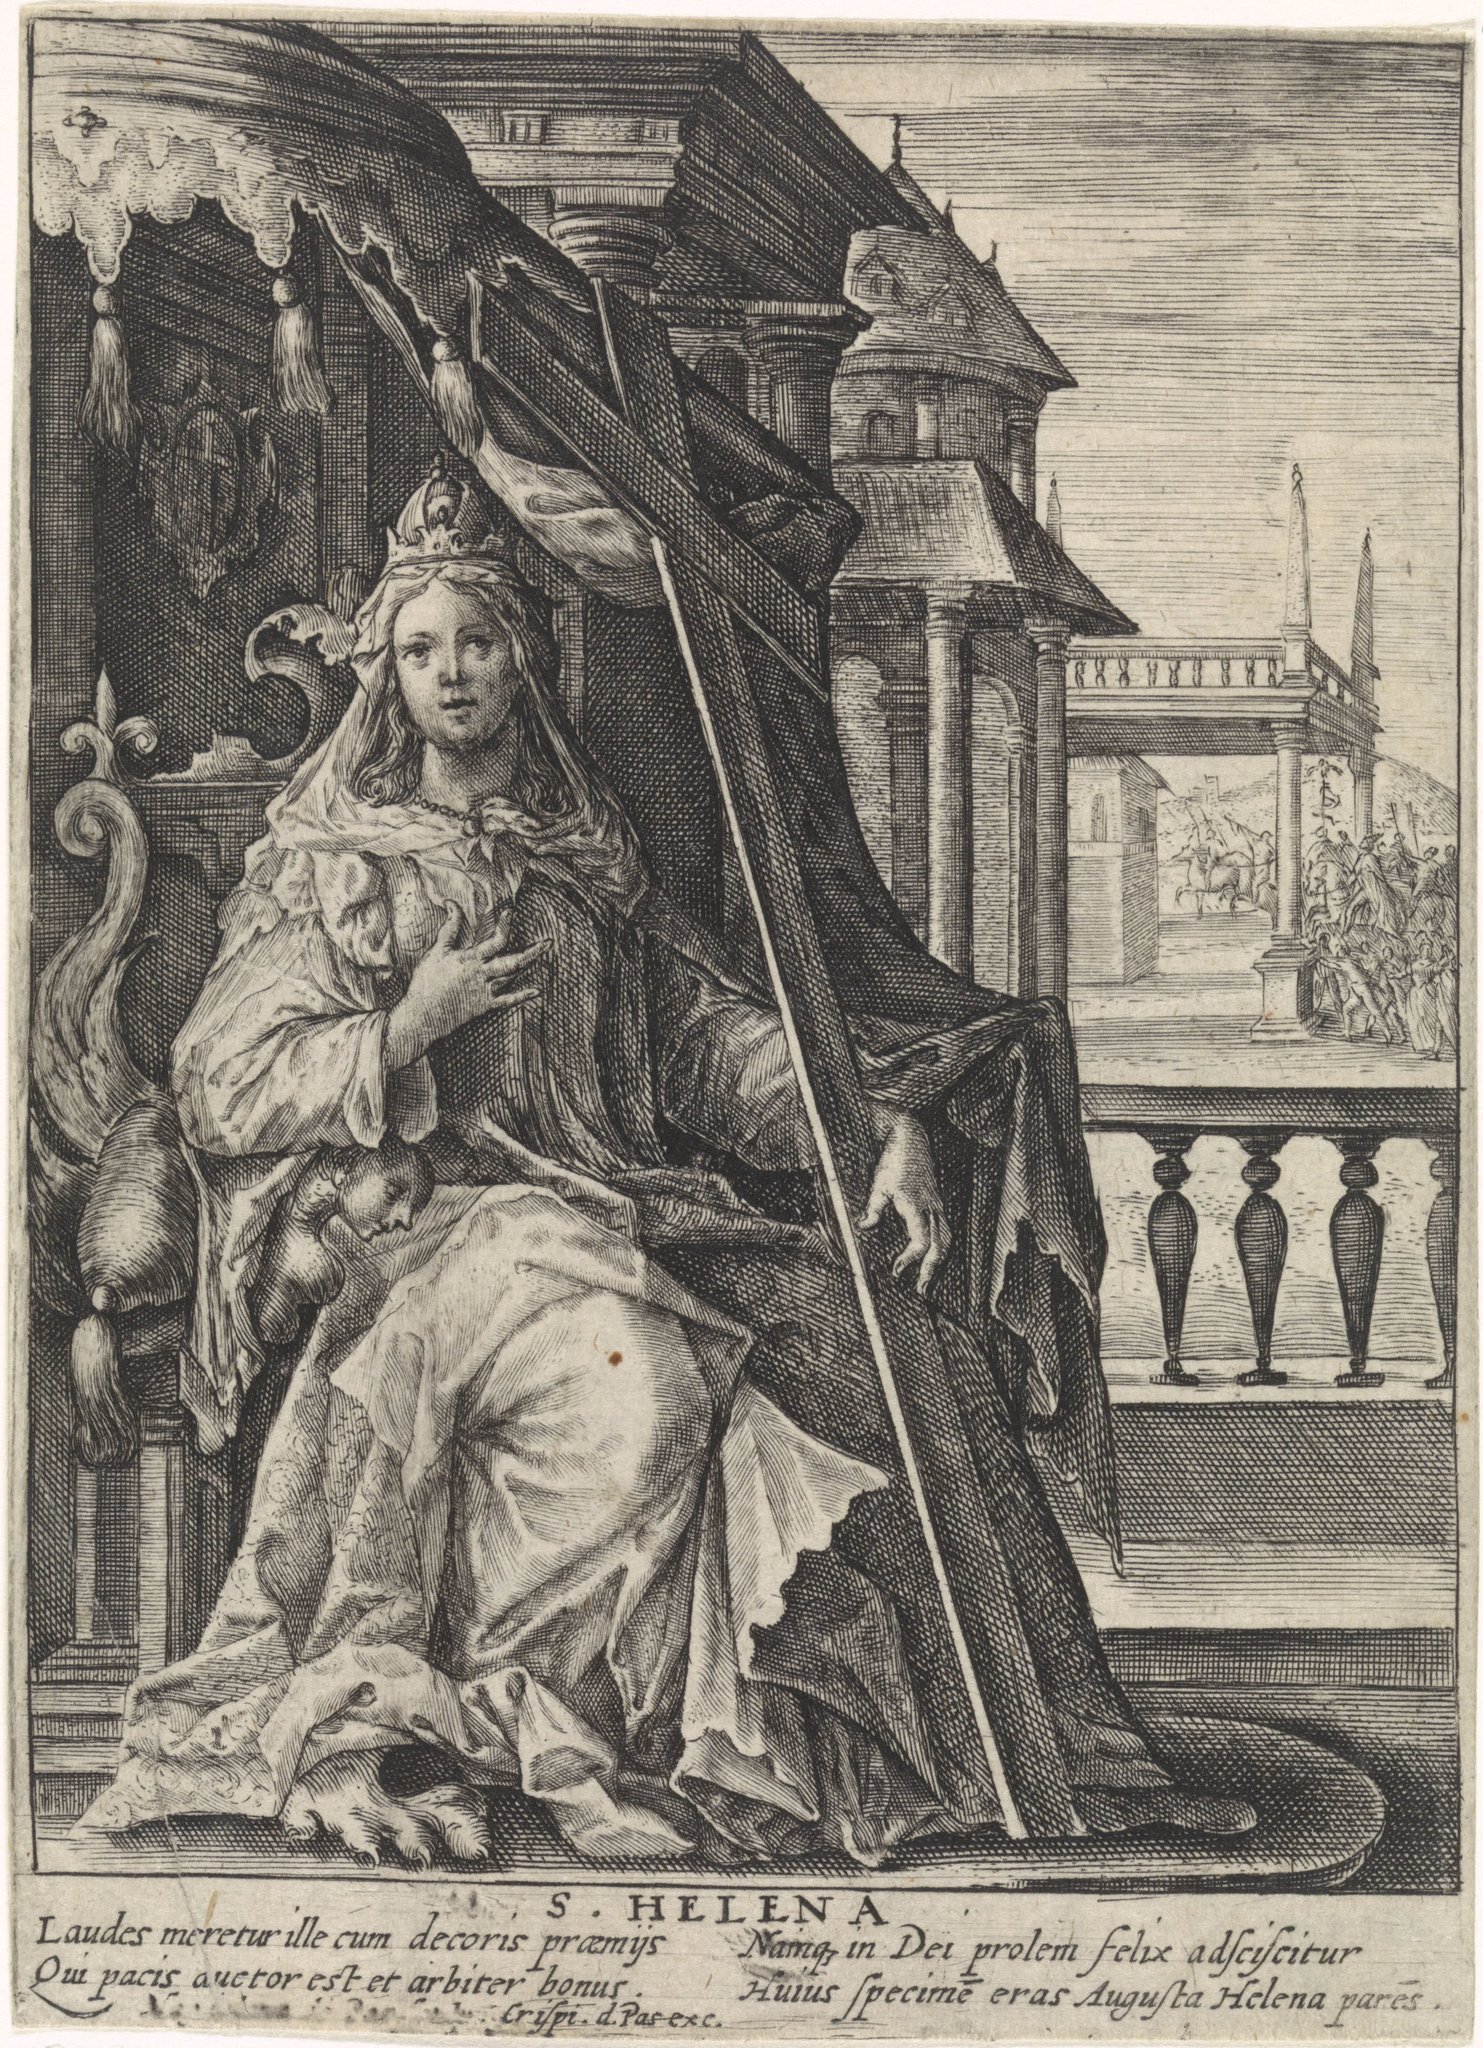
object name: print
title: Heilige Helena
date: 1574-1637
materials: paper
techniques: engraving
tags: st. helena (one of the nine worthiest women)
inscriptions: collector's mark: Lugt 2542, collector's mark: Lugt 2228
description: De H. Helena met het kruis in haar hand, zittend op een troon. In de marge een vierregelig onderschrift, in twee kolommen, in het Latijn.